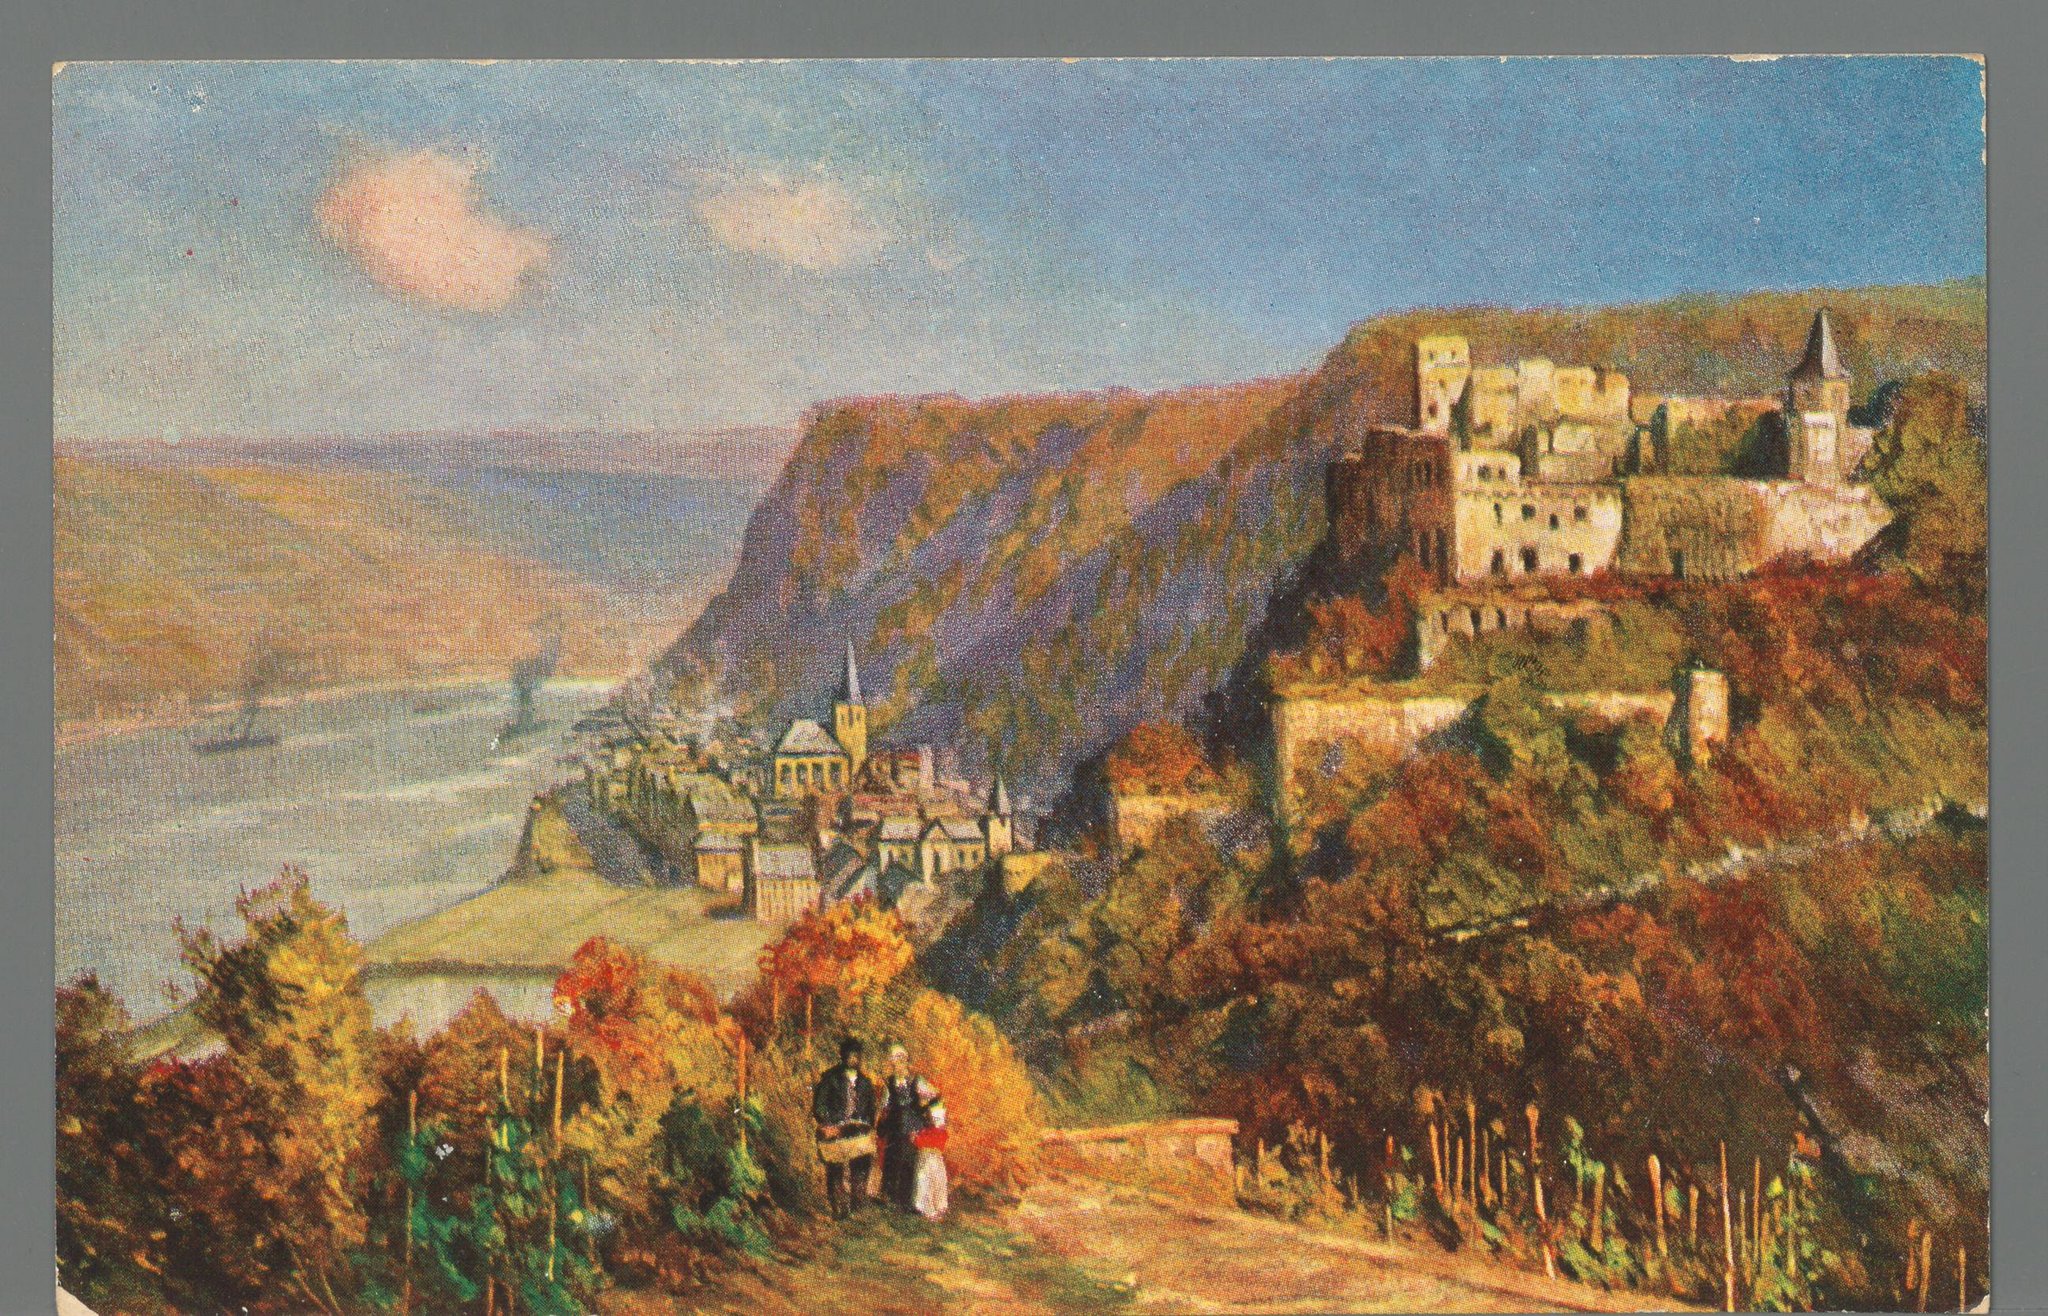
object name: photomechanical print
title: T.S.N. Serie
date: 1905-1930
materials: cardboard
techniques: color autotype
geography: nuremberg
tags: castle, river